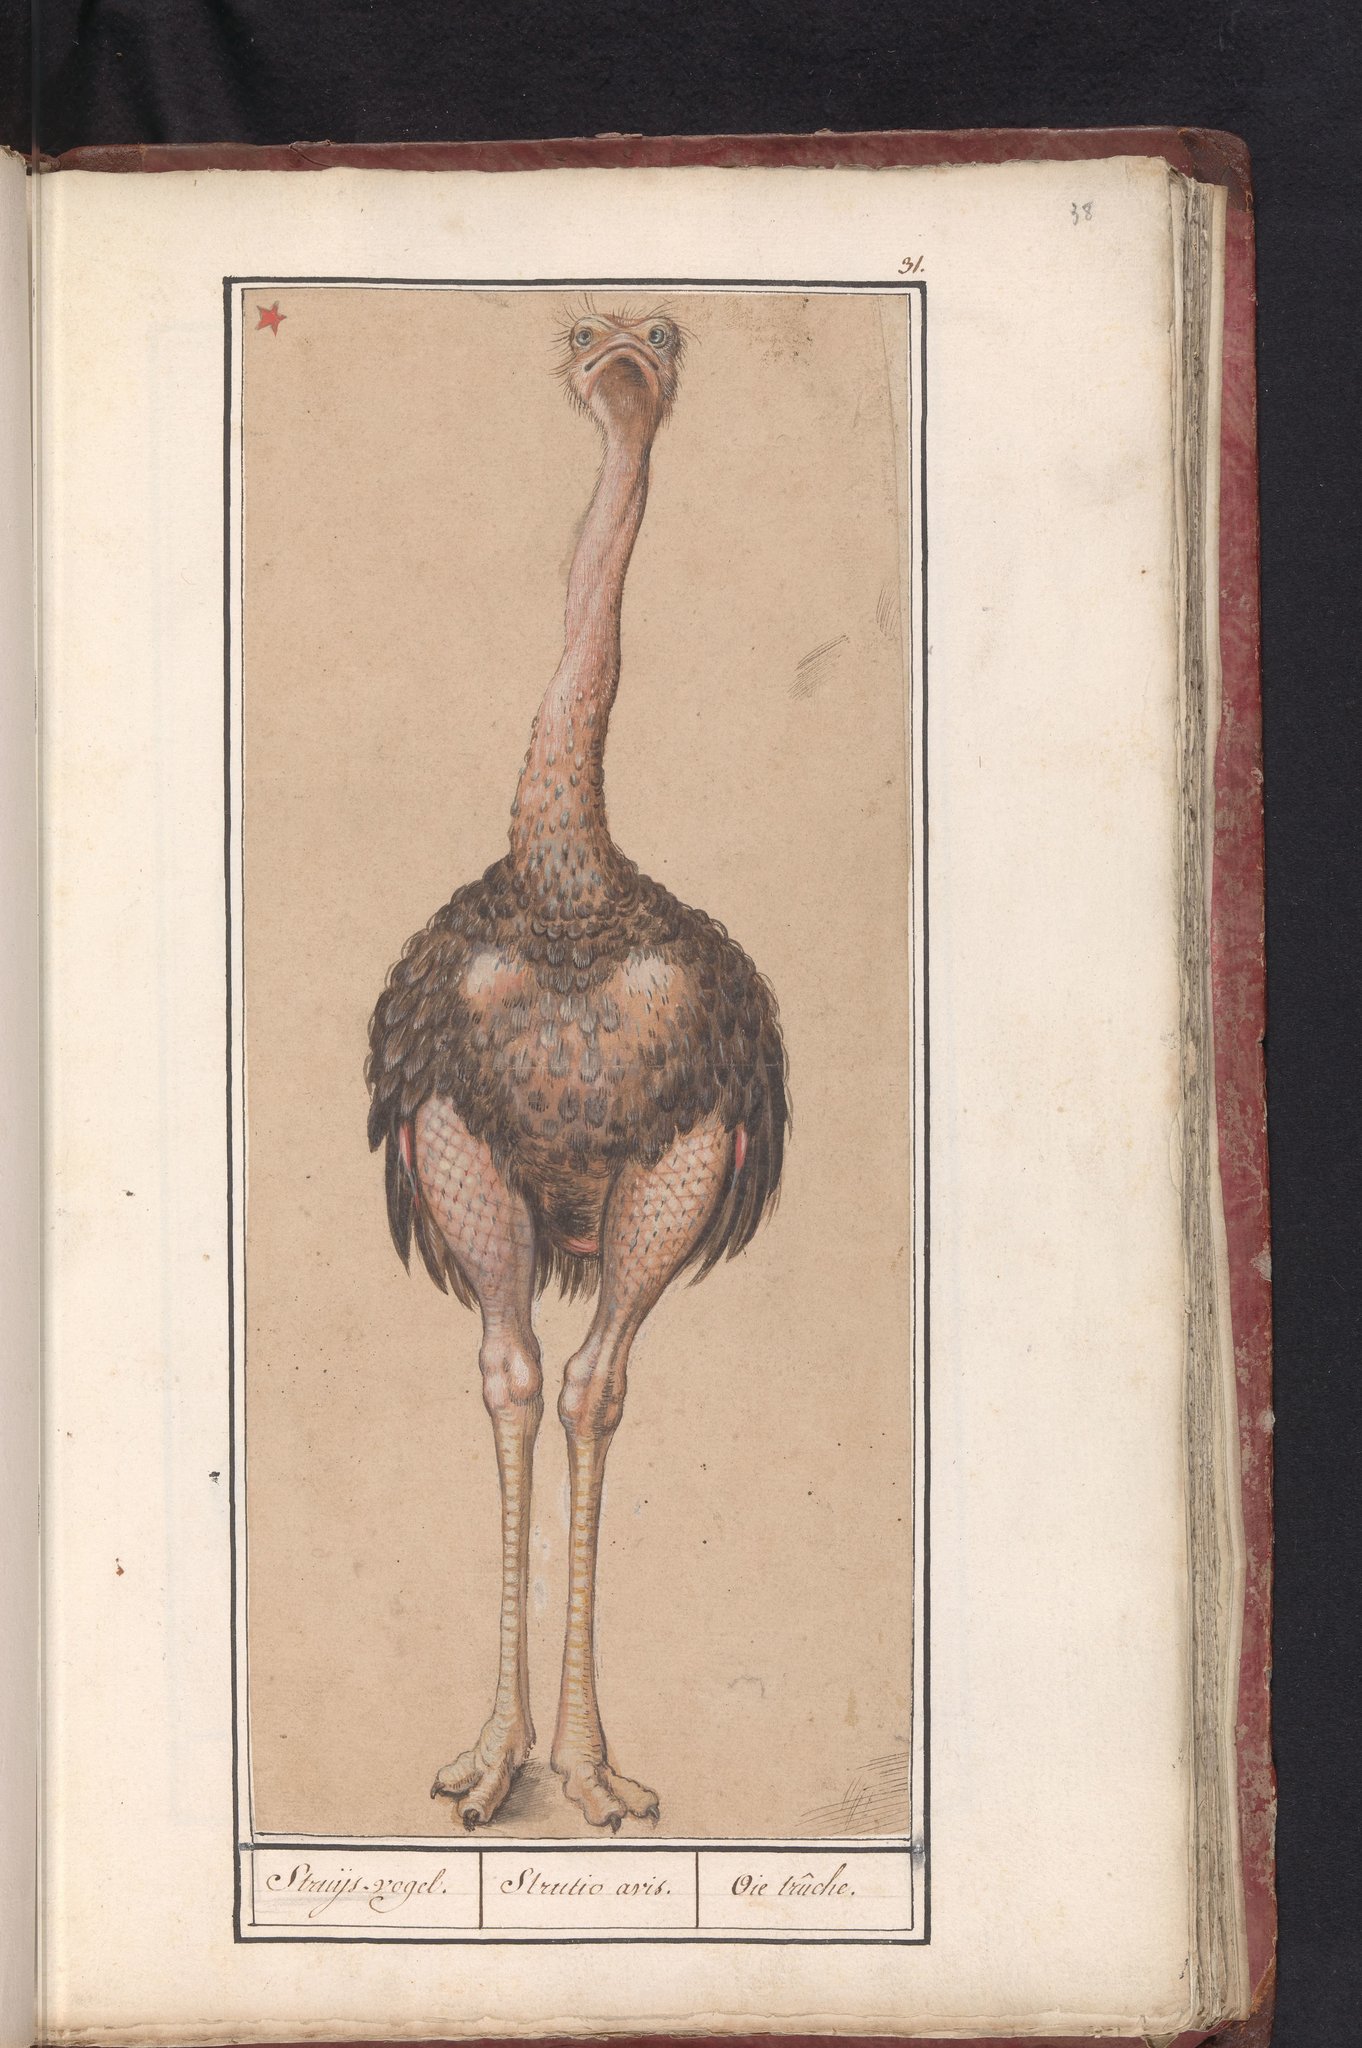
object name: drawing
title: Ostrich (Struthio camelus)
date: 1596-1610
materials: paint, ink, paper, pencil, watercolor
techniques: brush, pen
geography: southern netherlands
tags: walker and runner birds: ostrich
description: The Historia Naturalis aimed to give a reliable ‘scientific’ image for each subject. Yet some illustrations have a lively, humorous air that sets them apart from earlier zoological models. This comical ostrich, with its twisted neck and perplexed expression, has been tentatively attributed to fellow court artist Joris Hoefnagel, who painted the same motif in the background of two other watercolours once in Rudolph’s collection.